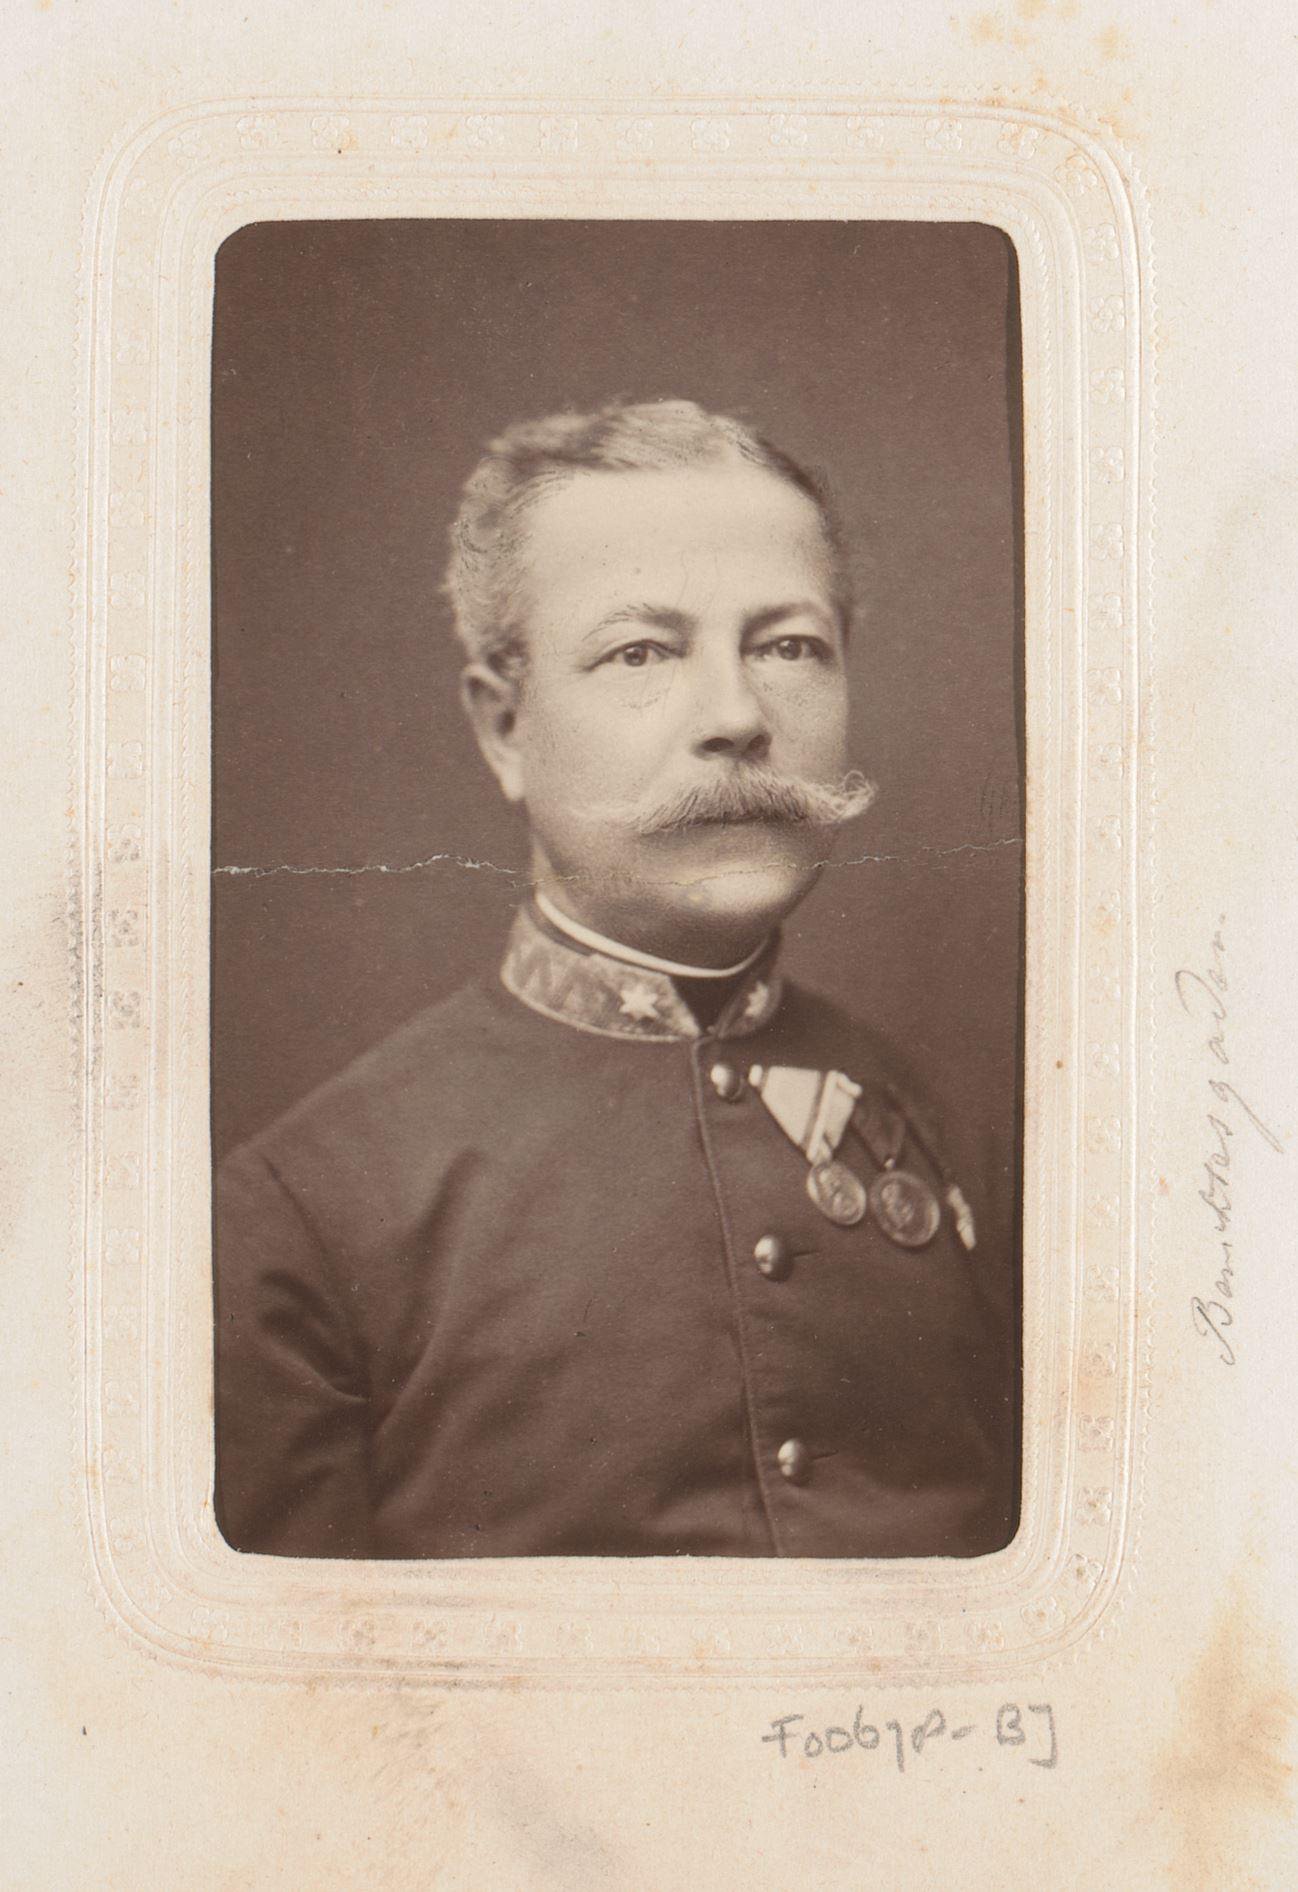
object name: photograph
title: Portret van een militair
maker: august thiry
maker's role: fotograaf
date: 1860-1880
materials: cardboard, photographic support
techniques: albumen print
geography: nový jicín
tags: historical persons, (military) uniforms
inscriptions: inscription: ‘Fotografisches Atelier von August Thiry in Neutitschein No. 687’, annotation: ‘Berchtesgaden’